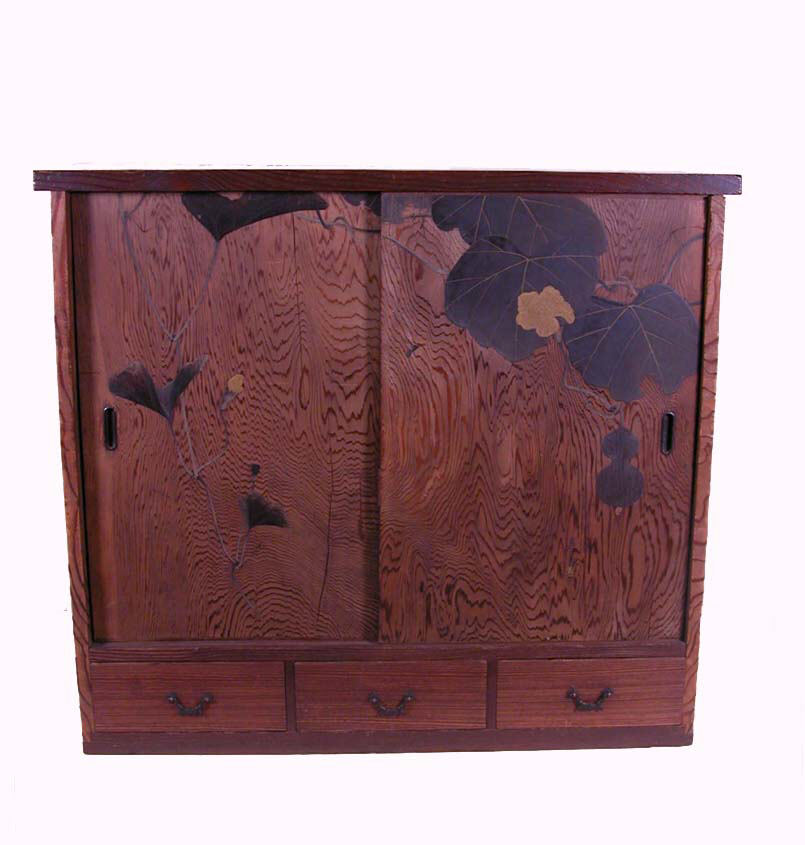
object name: chest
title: Chest with Decoration of Gourd Vine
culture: japanese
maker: shibata zeshin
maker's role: artist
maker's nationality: japanese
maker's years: 1807-1891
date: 1878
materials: gold, lacquer, wood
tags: vines,chests